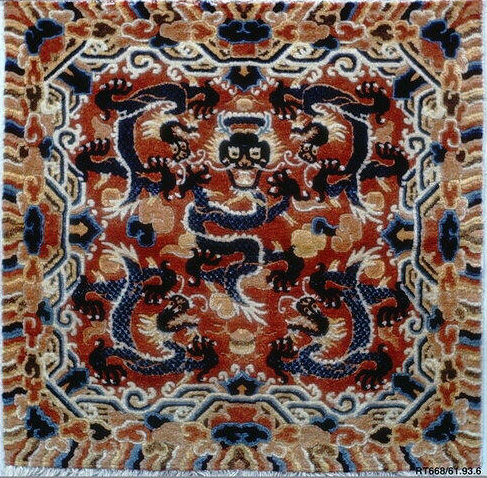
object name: rug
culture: chinese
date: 1701-1900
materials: cotton, wool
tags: dragons